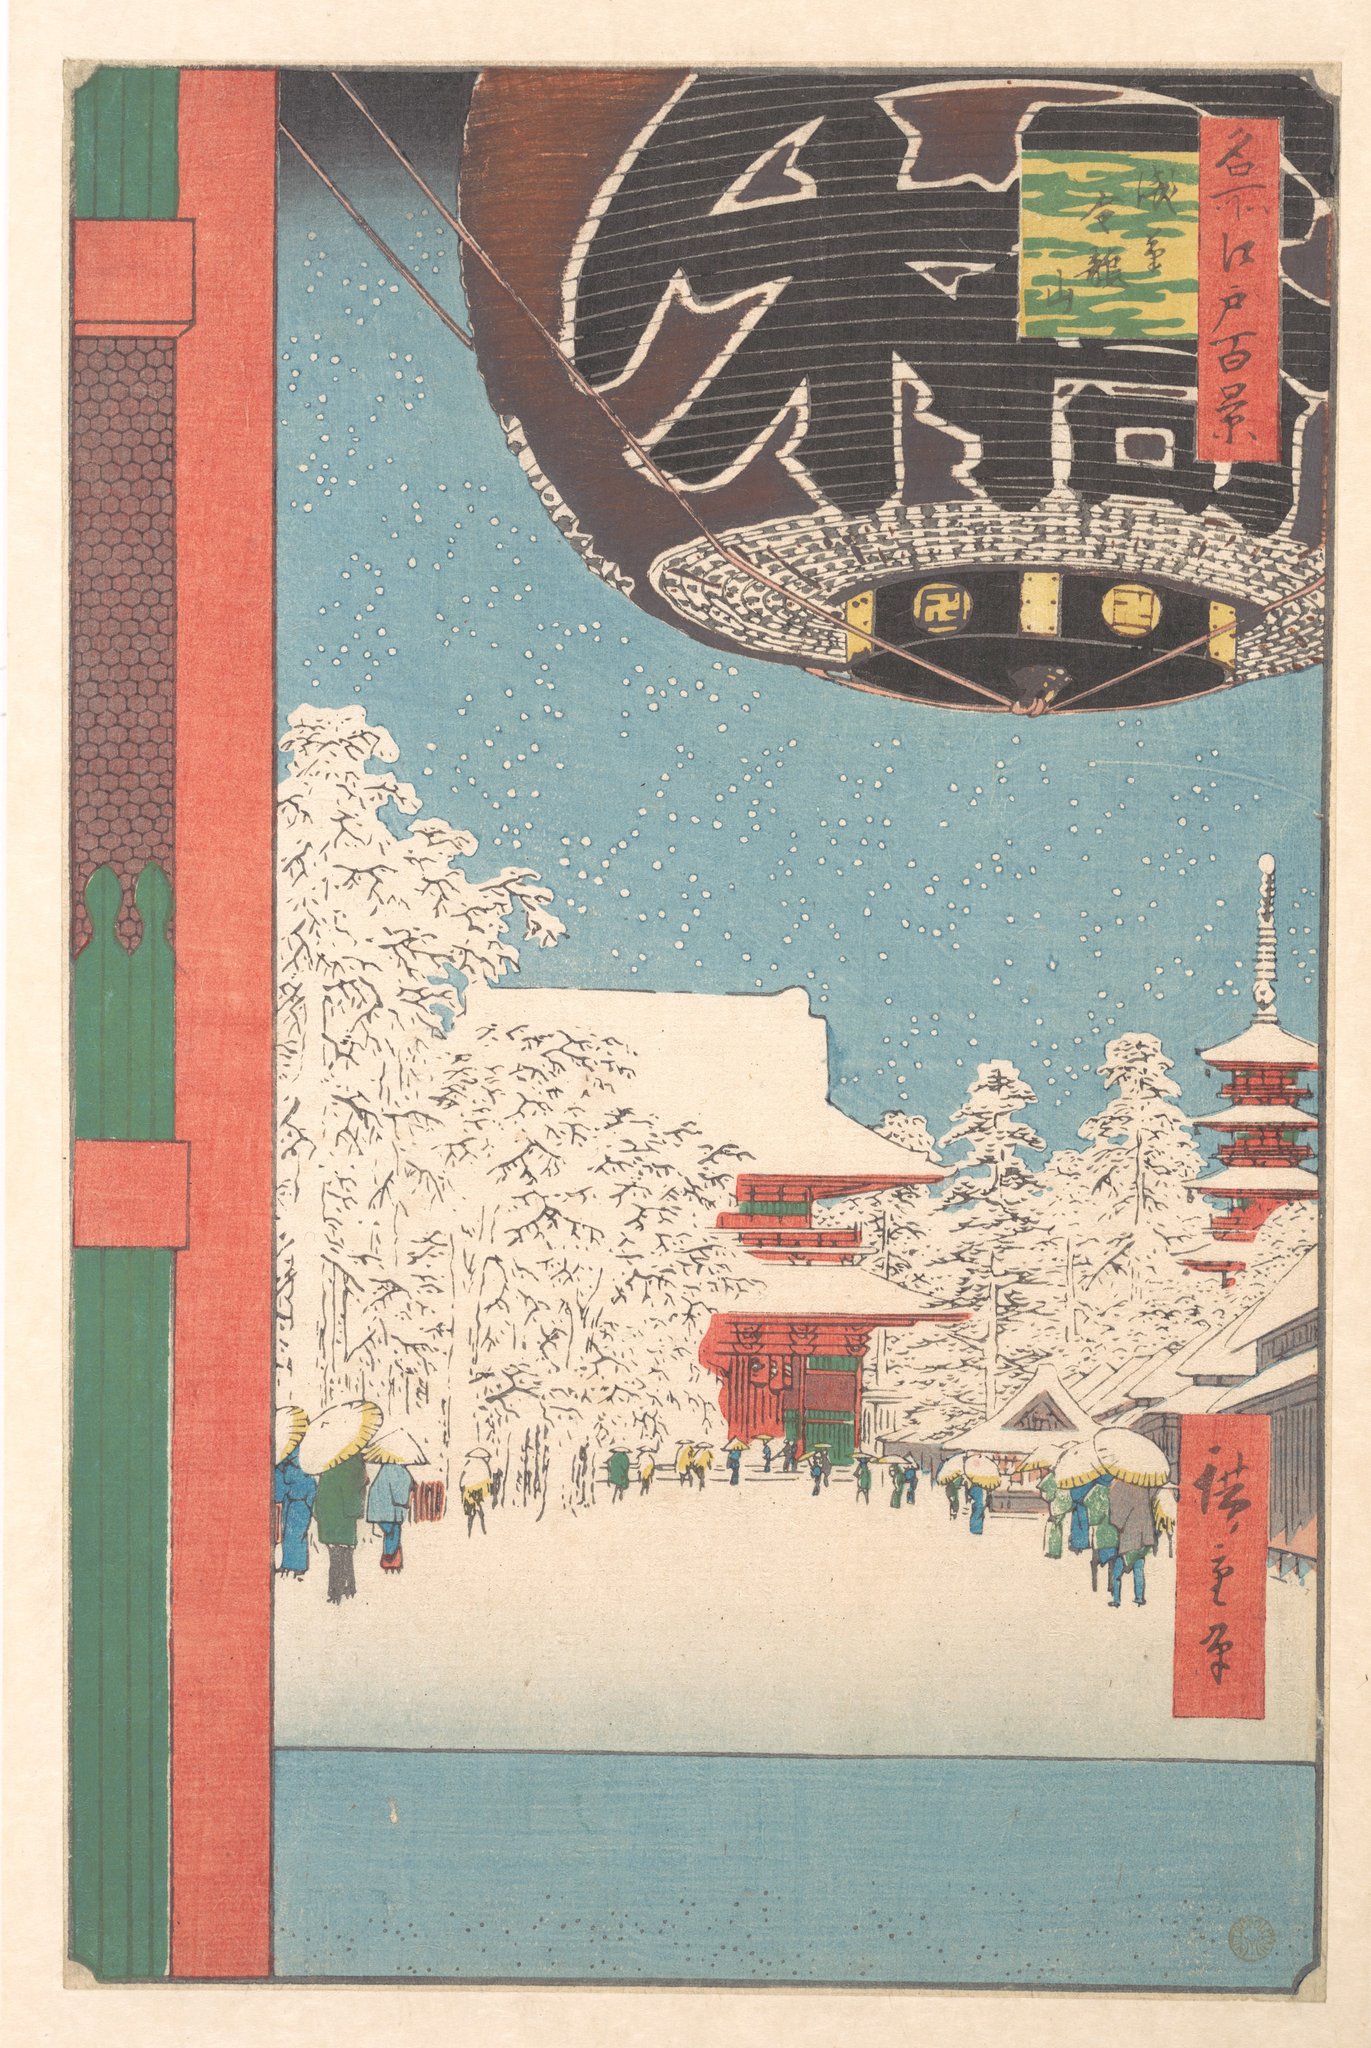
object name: print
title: The Kinryusan Temple at Asakusa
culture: japanese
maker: utagawa hiroshige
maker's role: artist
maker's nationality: japanese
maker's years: 1797-1858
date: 1856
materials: ink, paper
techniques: woodblock print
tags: human figures,temples,trees,snow